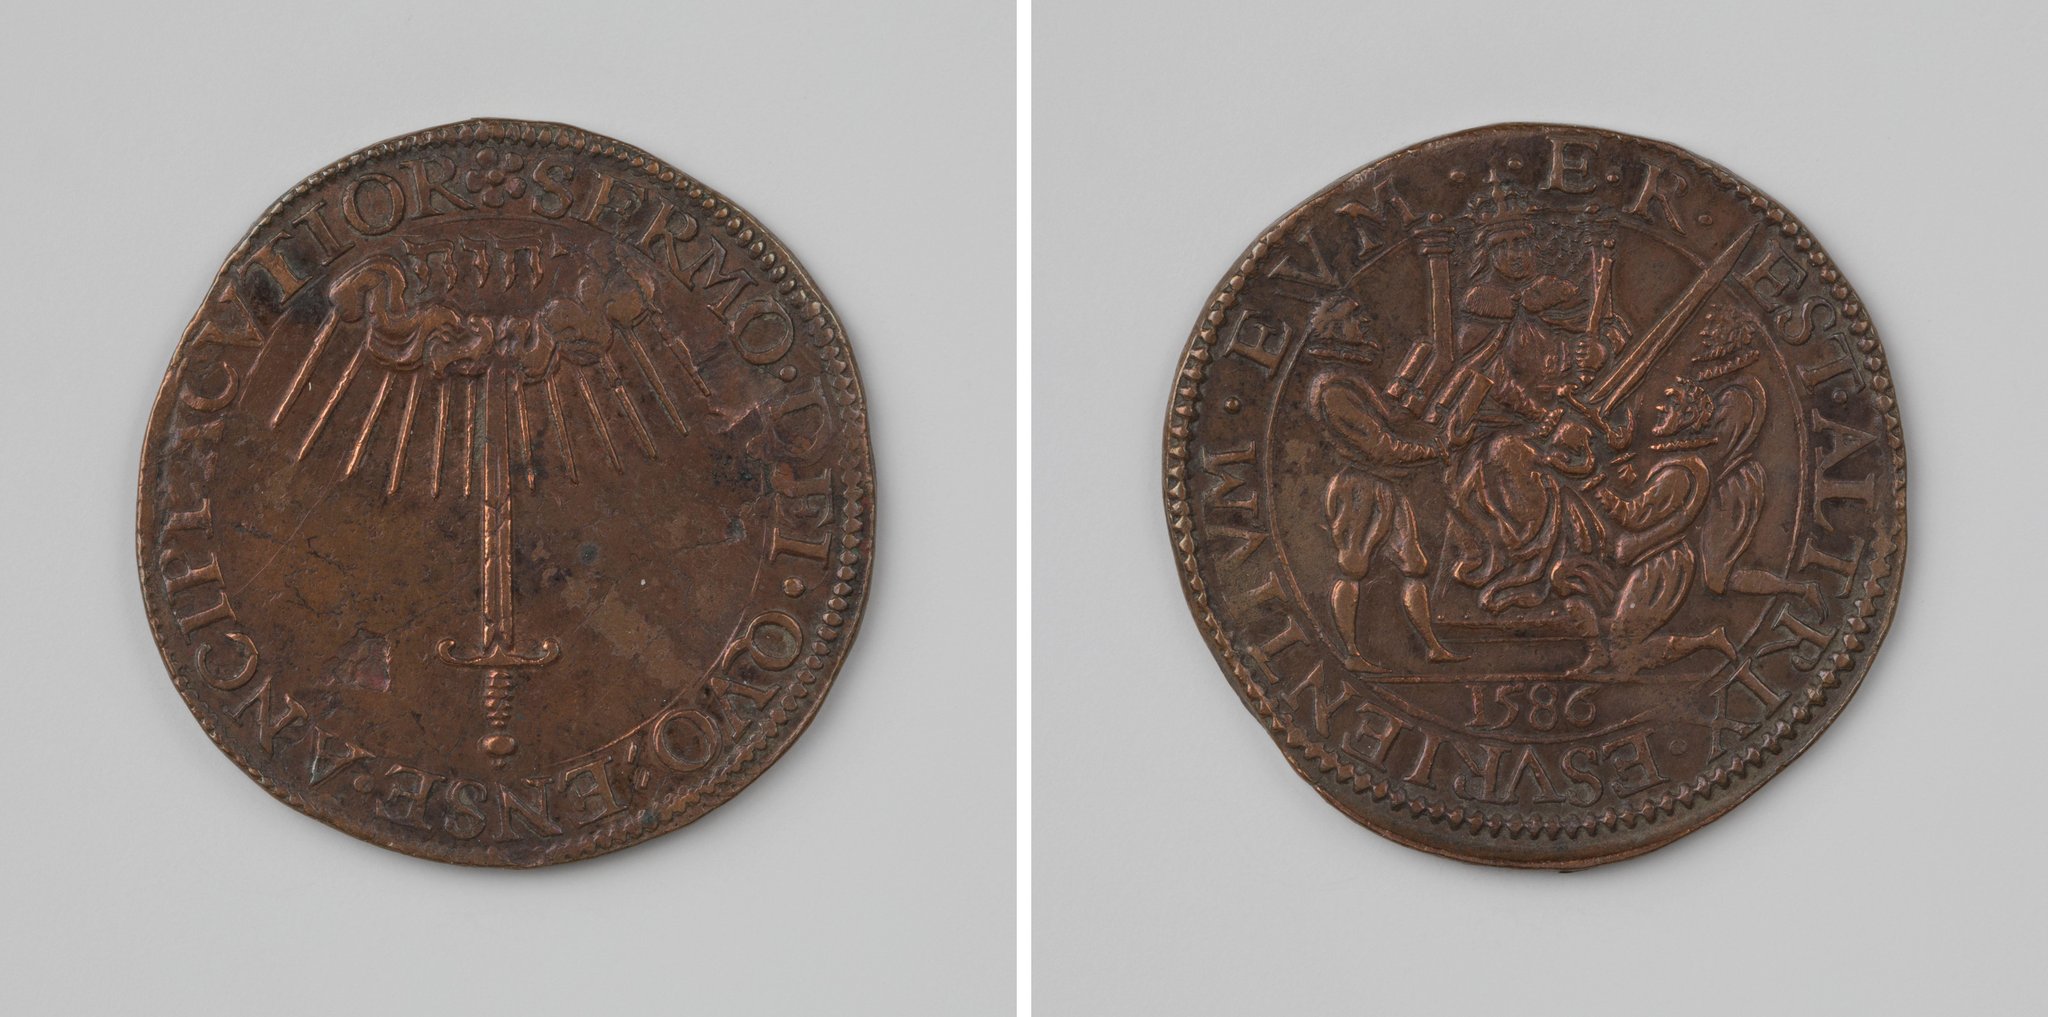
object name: jeton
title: Engelse hulp aan de opstandelingen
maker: Anonymous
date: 1586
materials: copper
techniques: striking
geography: dordrecht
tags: greenwich, richmond (surrey), koningin, elizabeth i tudor (koningin van engeland), tachtigjarige oorlog